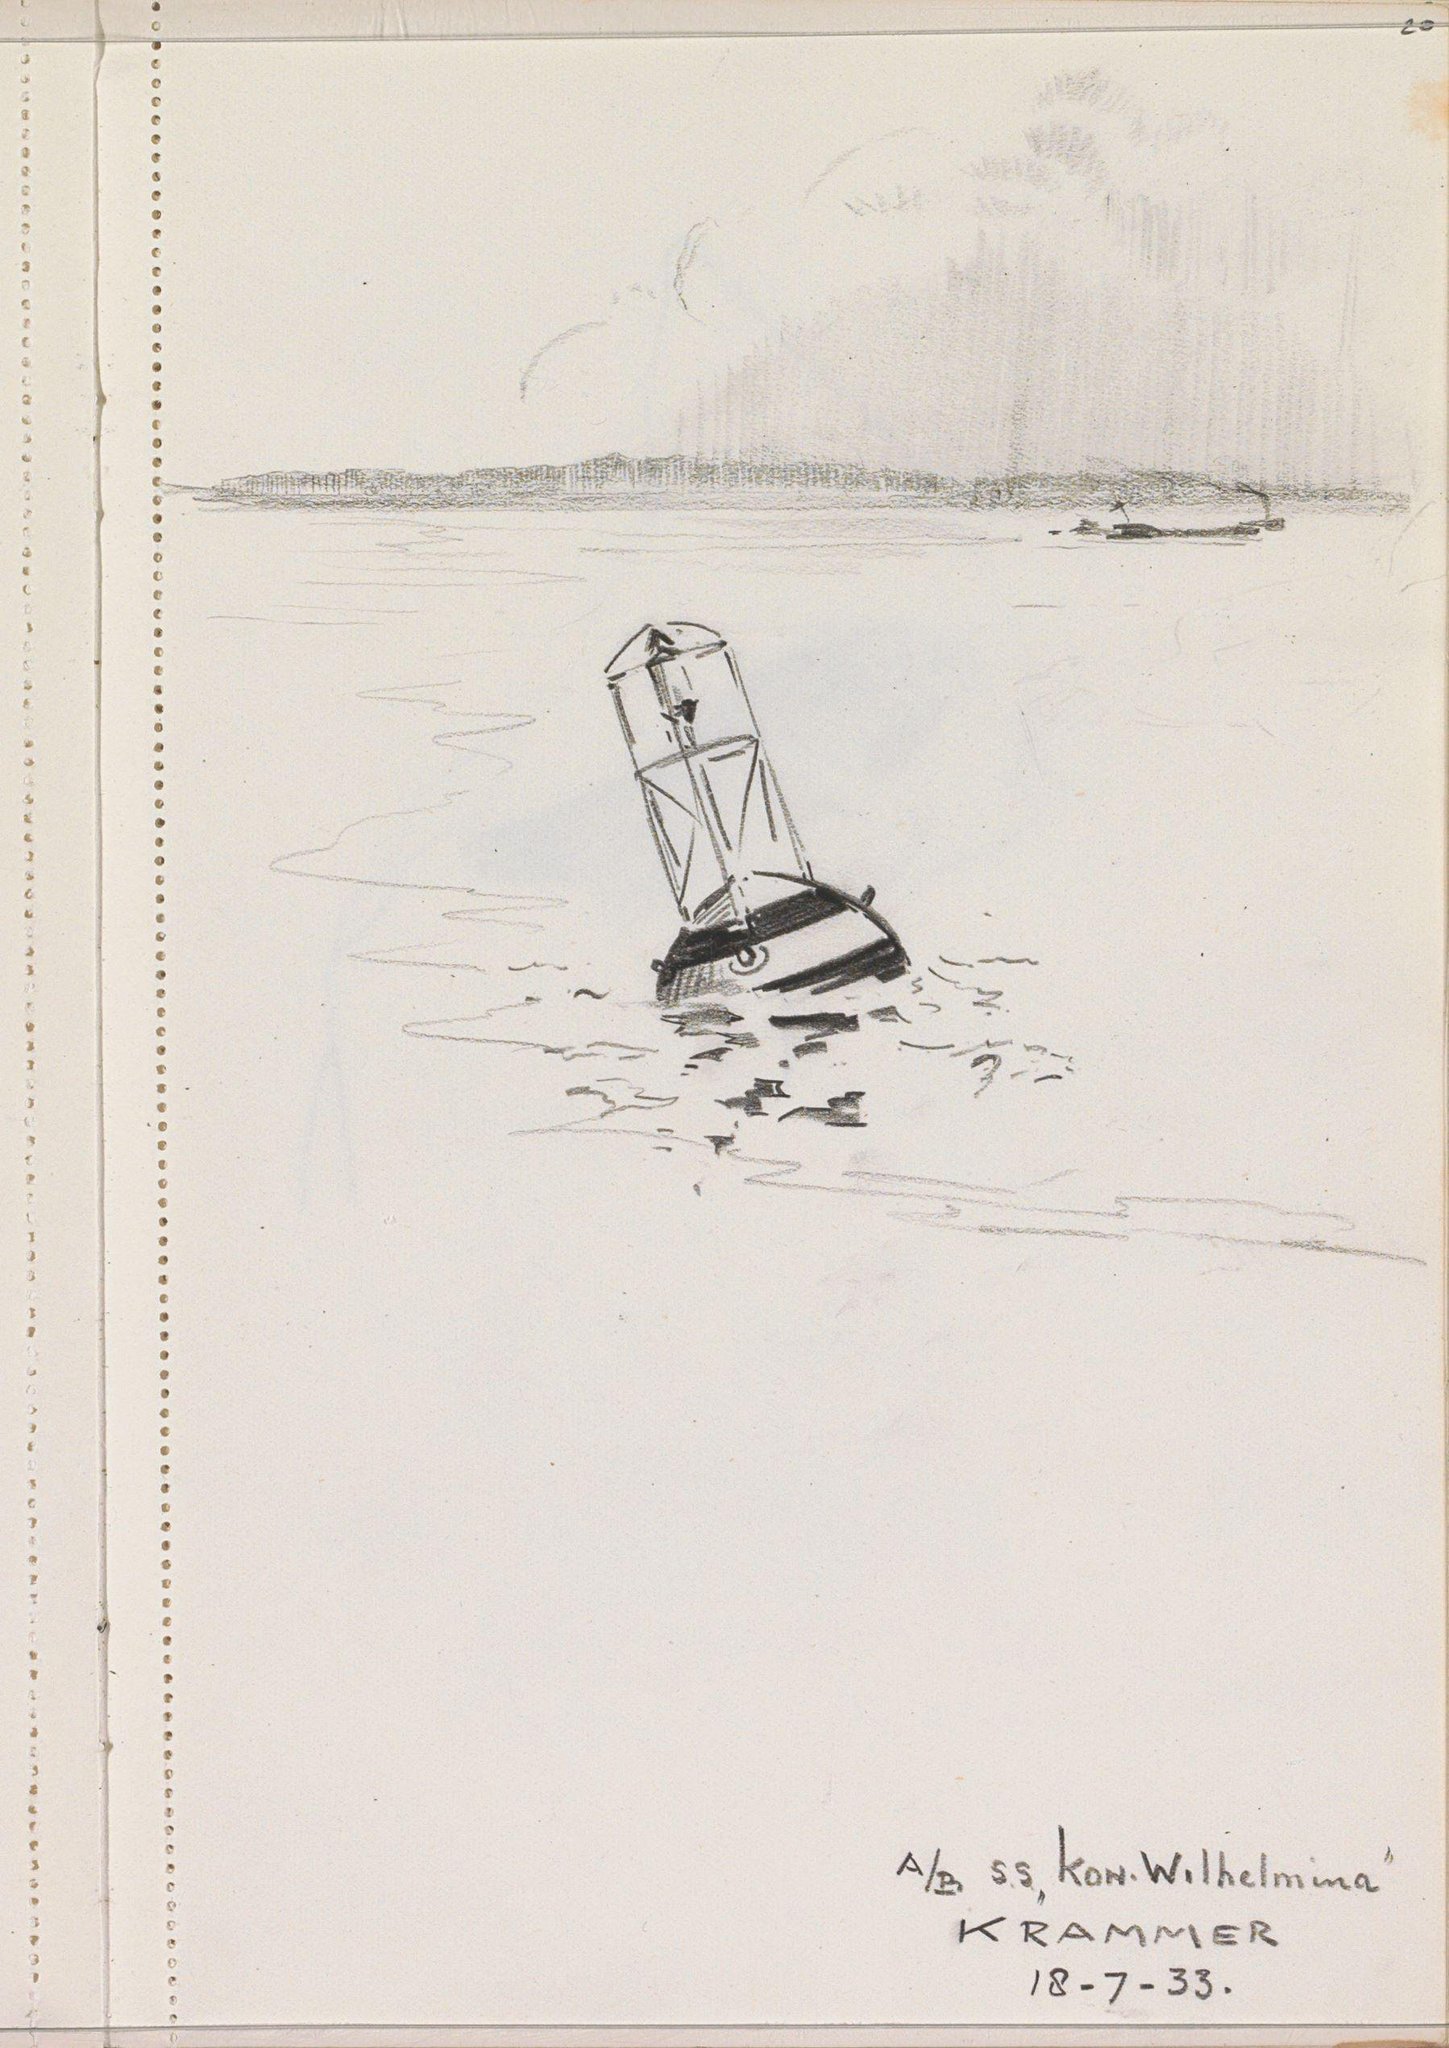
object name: sketchbook leaf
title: Boei op het water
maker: otto verhagen (i)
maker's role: draughtsman, print maker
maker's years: 1885-1951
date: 1907-1933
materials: chalk, paper, pencil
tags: bell-buoy, whistling-buoy, landscapes with waters, waterscapes, seascapes (in the temperate zone)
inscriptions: date and inscription: ‘A/B S.S, kon. Wilhelmina"/ KRAMMER/ 18-7-33.’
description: Pagina 19 uit een schetsboek met 60 bladen.